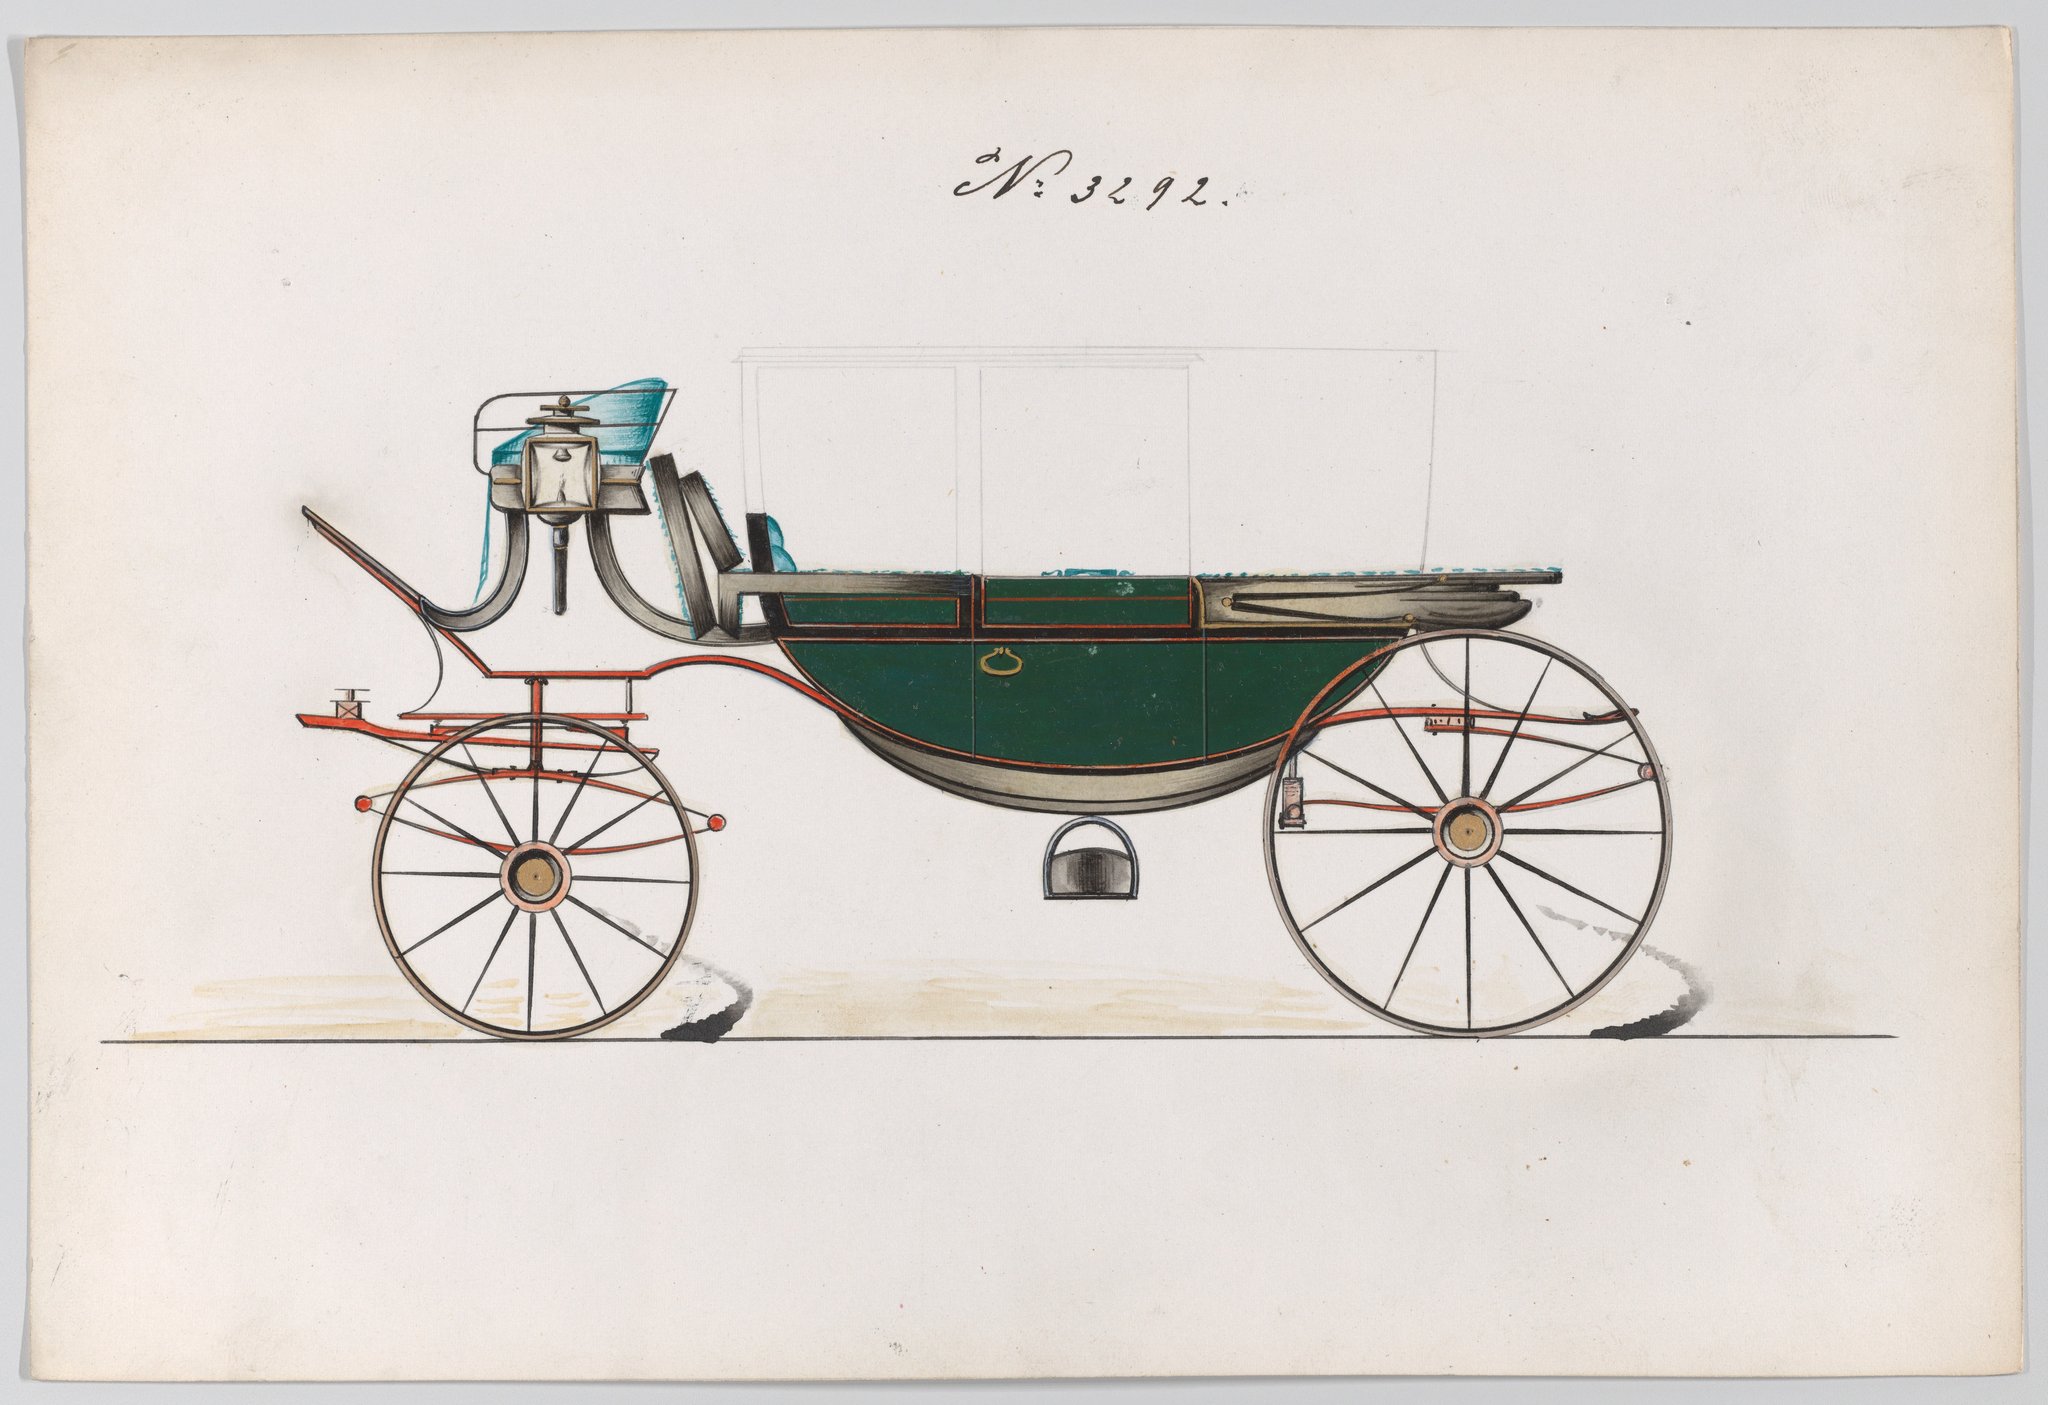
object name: drawing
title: Design for Landau, No. 3292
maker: brewster & co.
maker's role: manufacturer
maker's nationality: american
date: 1877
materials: gouache, gum arabic, ink, watercolor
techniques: pen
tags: carriages